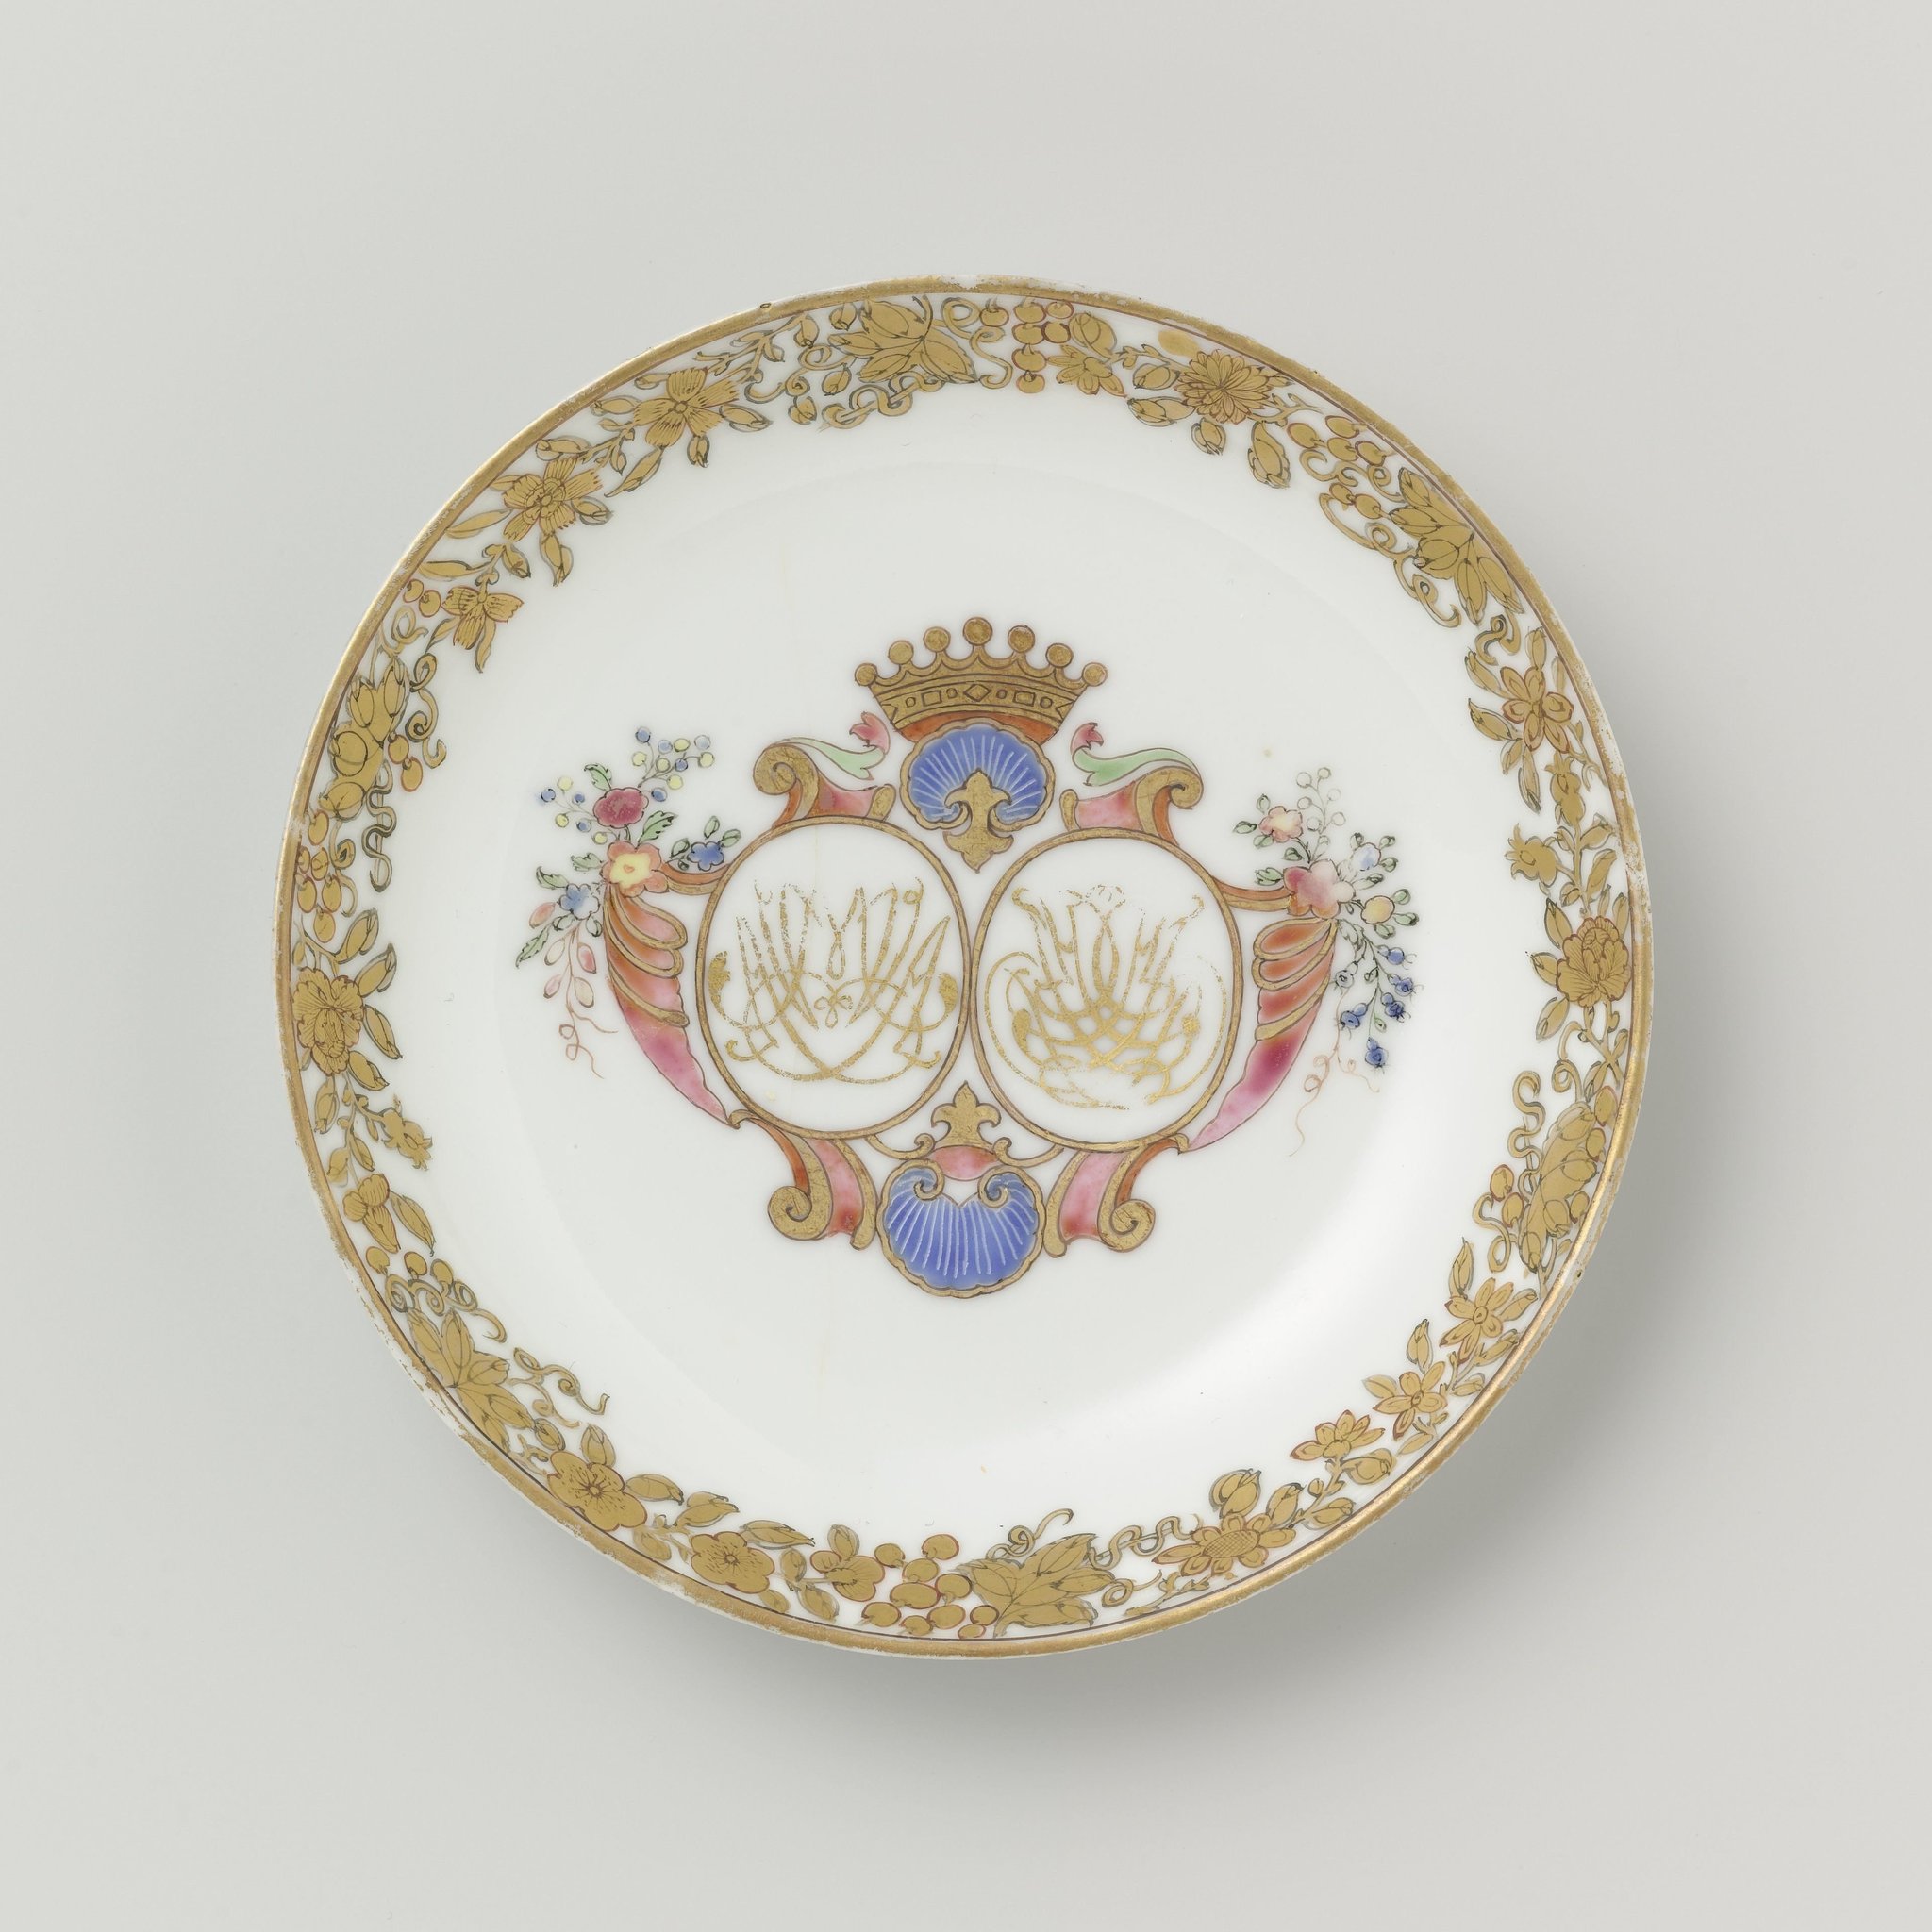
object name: platter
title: Saucer from the 'Swellengrebel service' with a double crowned monogram and a border with floral scrolls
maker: Anonymous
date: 1740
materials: glaze, gold, paint, porcelain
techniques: firing, gilding, turning, vitrification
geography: china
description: De monogrammen 'MVA' en 'CHTD' staan voor Maurits van Aerden (1694-1746) en Constantia Helena ten Damme (1694-1772), getrouwd in 1716. Het servies is waarschijnlijk besteld ter ere van hun vijfentwingtigjarig huwelijksjubileum in 1741. (Campen, Jan van & Hartkamp-Jonxis, Ebeltje, Aziatische weelde : VOC-kunst in het Rijksmuseum, Zutphen 2011, p. 78)